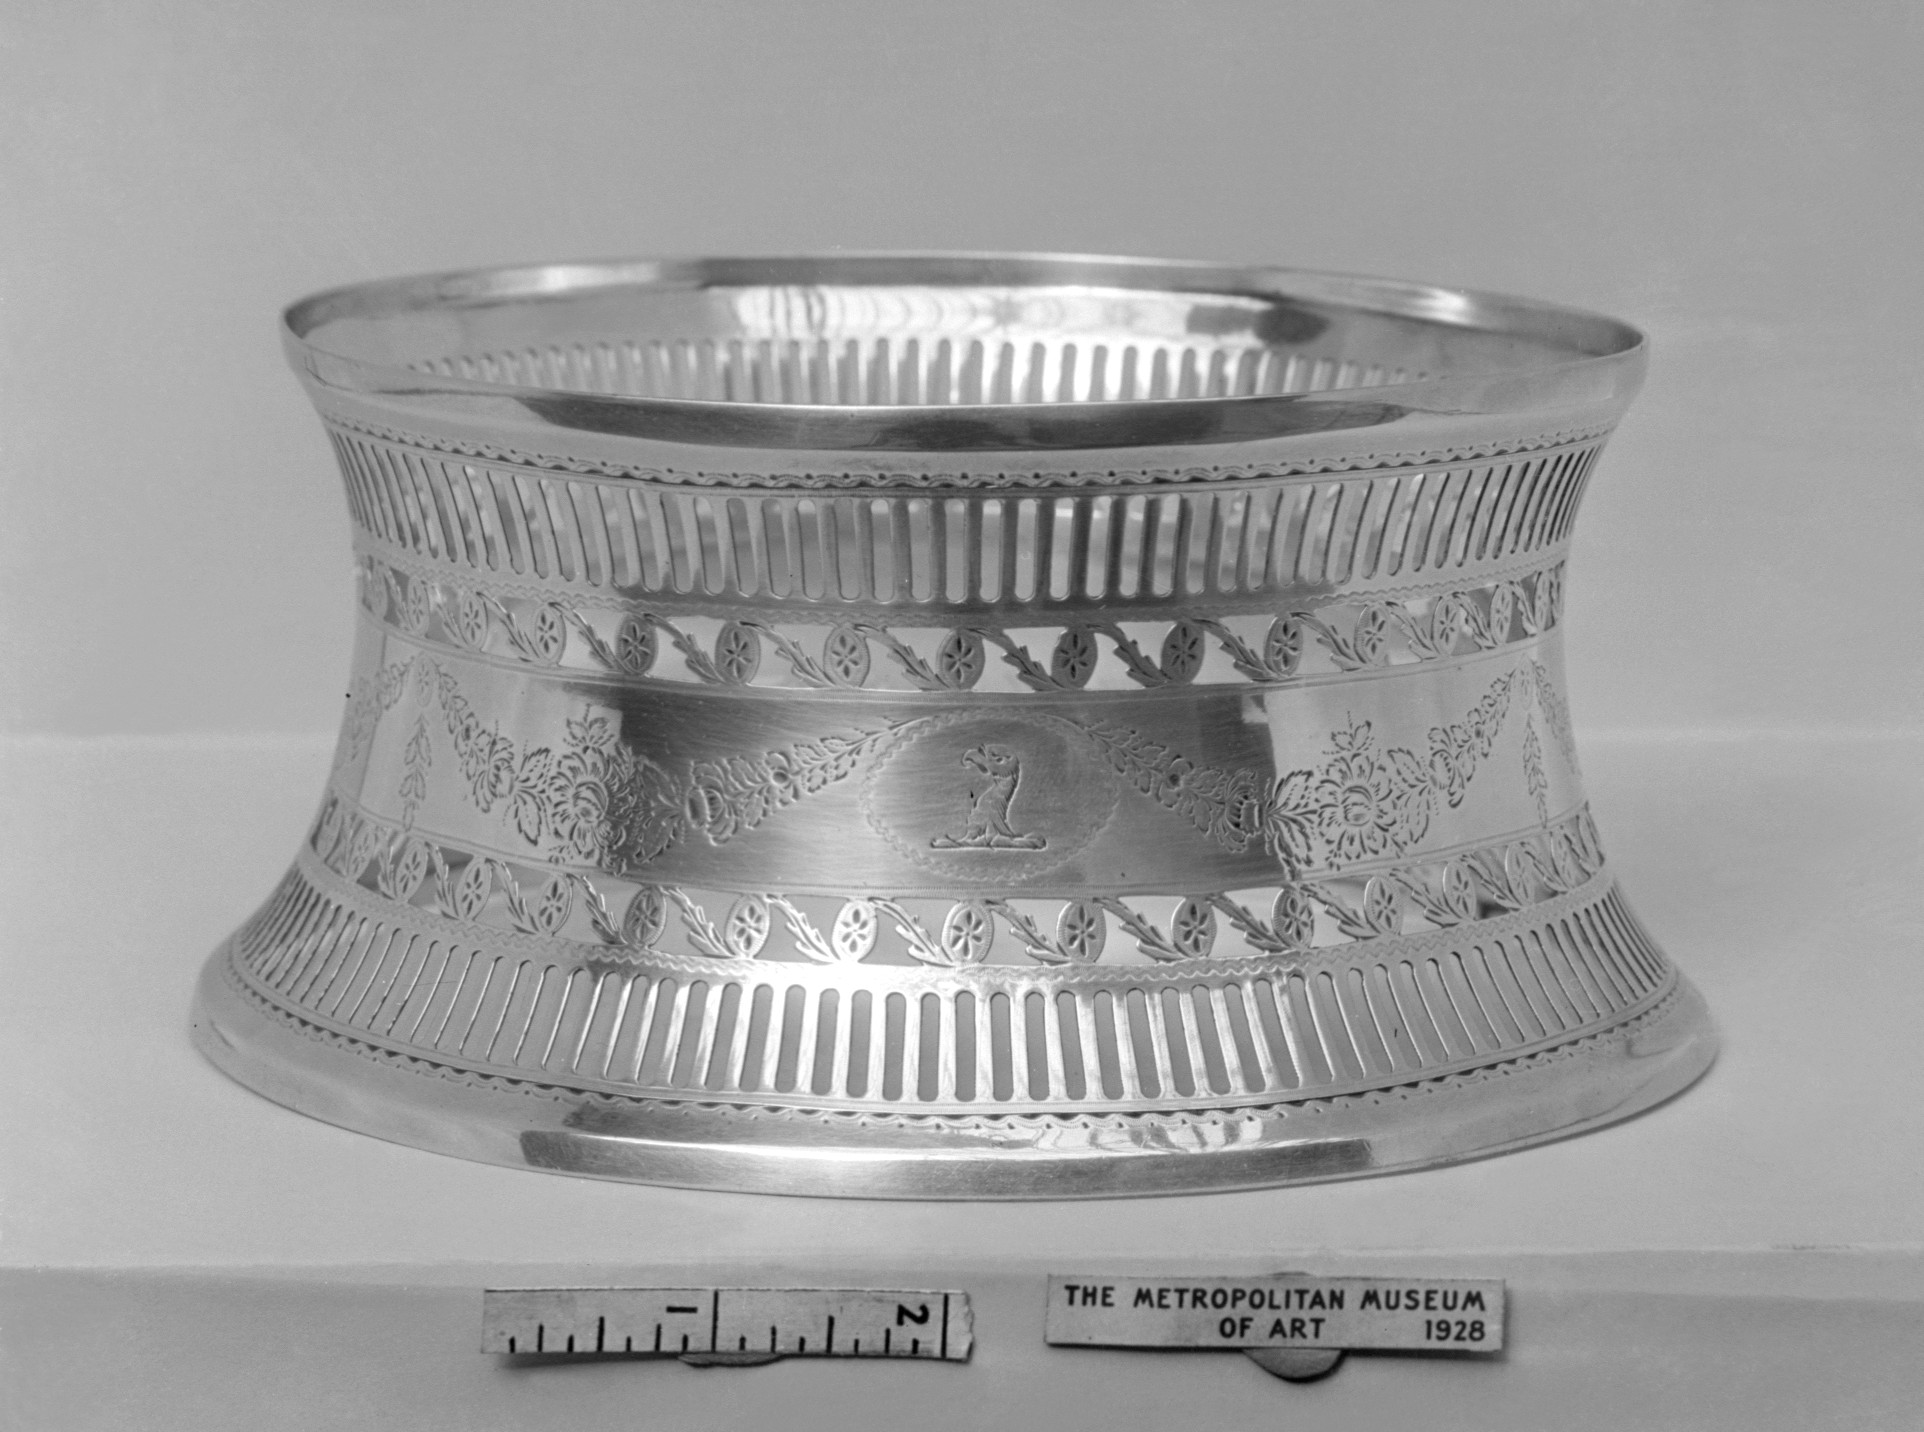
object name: dish ring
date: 1786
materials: glass, silver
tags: flowers